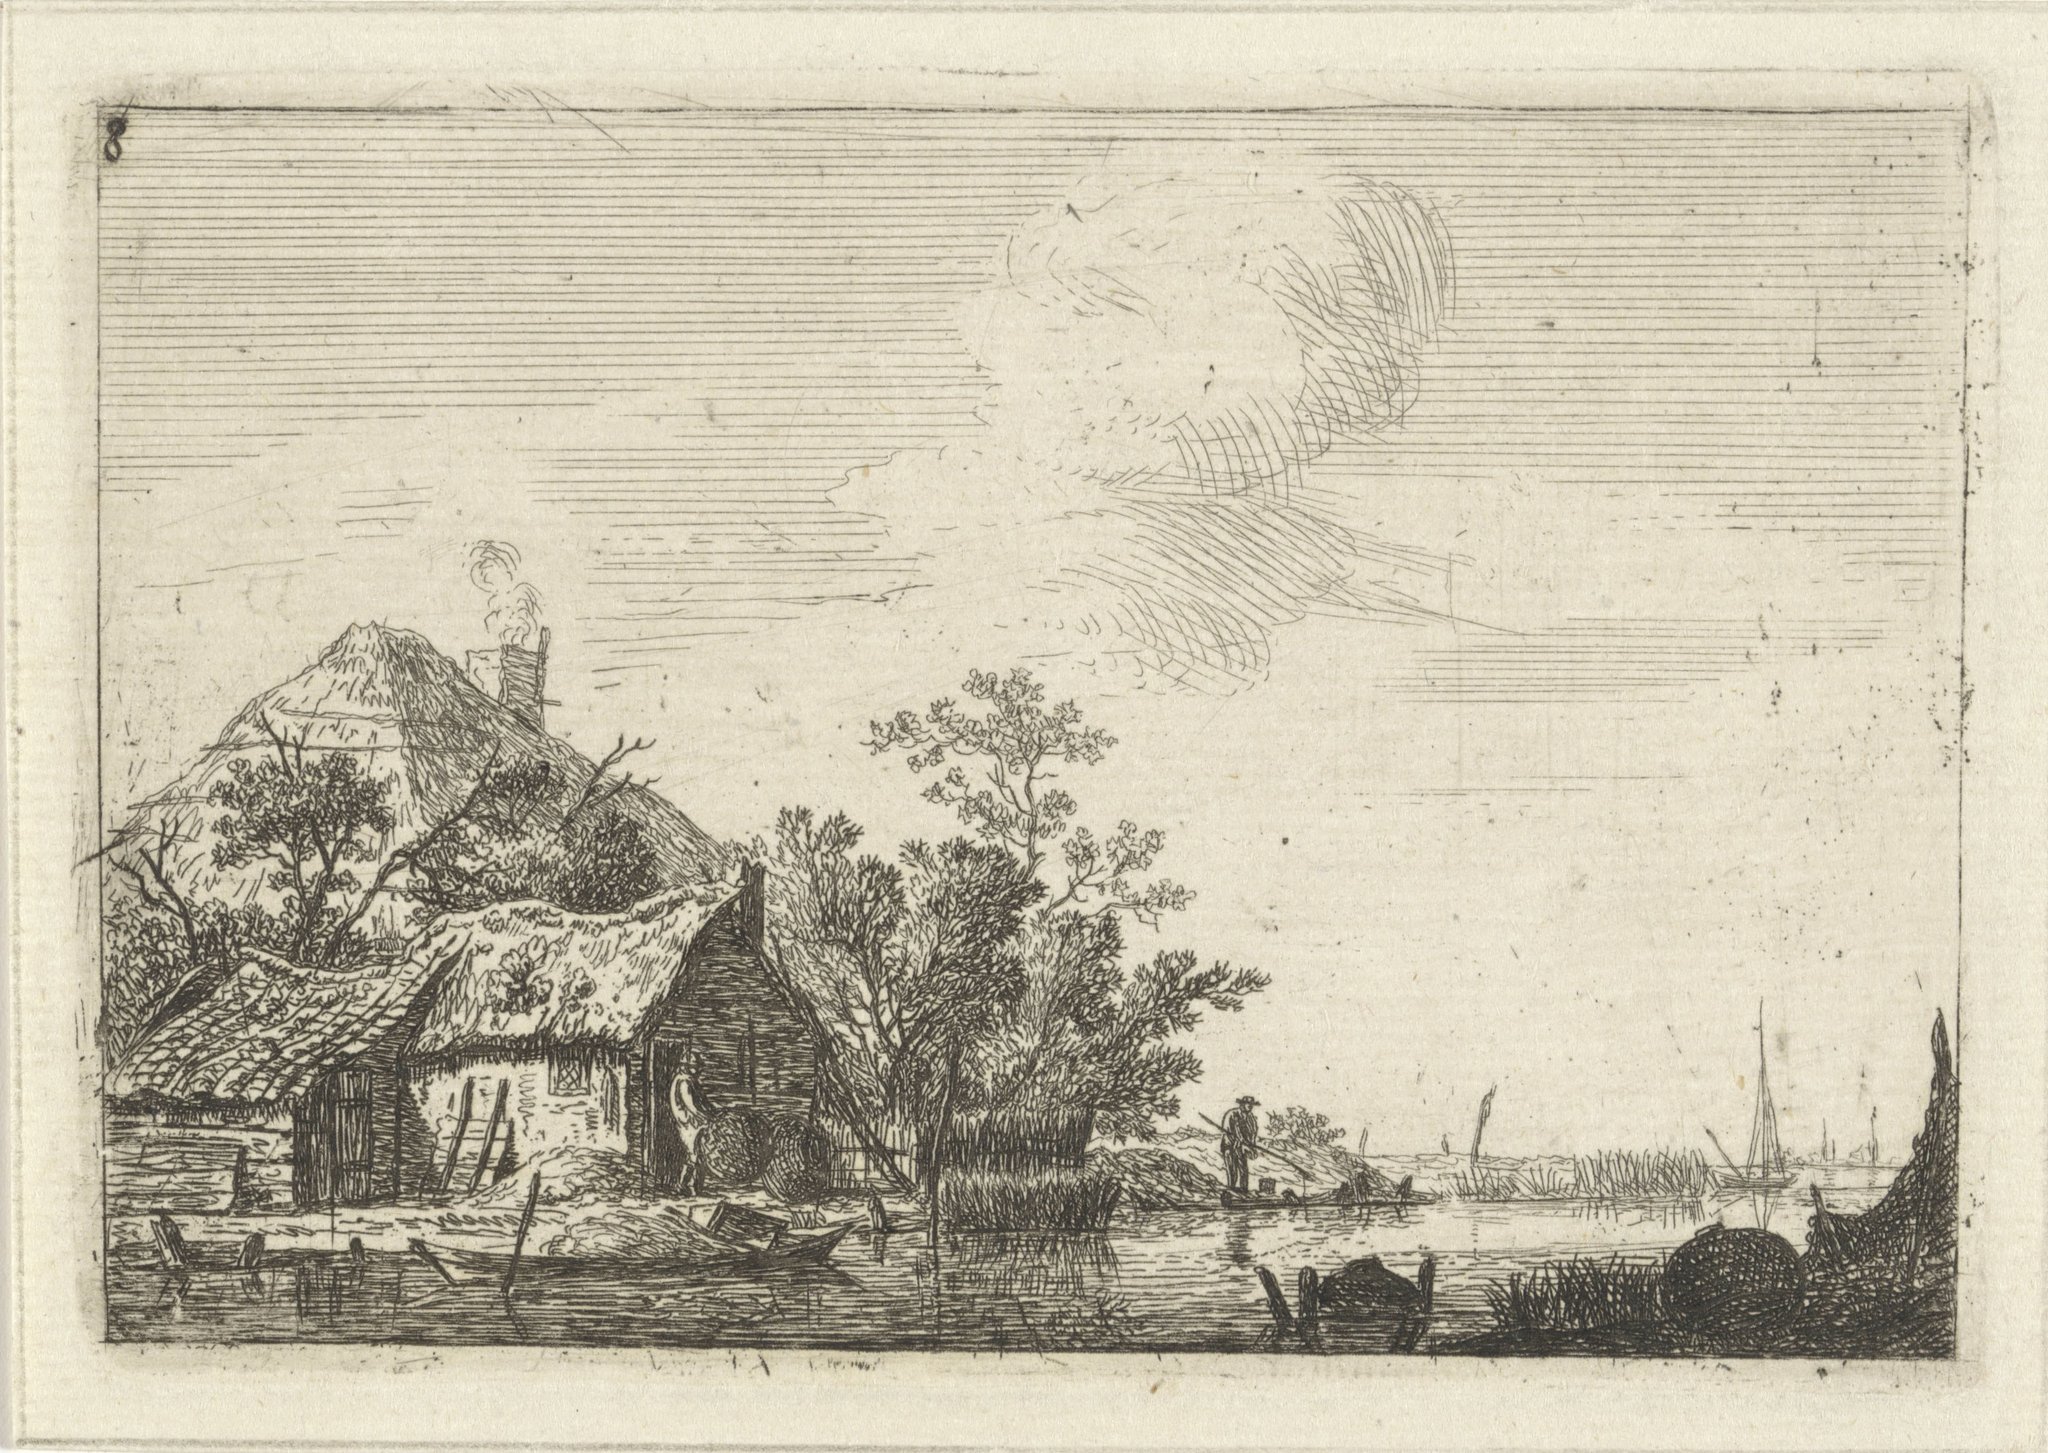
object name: print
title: Landschap met boerderij, hengelaar en fuiken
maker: hendrik schwegman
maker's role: draughtsman, print maker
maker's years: 1761-1816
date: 1786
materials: paper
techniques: etching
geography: haarlem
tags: farm or solitary house in landscape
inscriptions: collector's mark: Lugt 2228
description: Landschap met een boerderij aan het water. Langs het water staat een hengelaar. Rechts op de voorgrond fuiken.